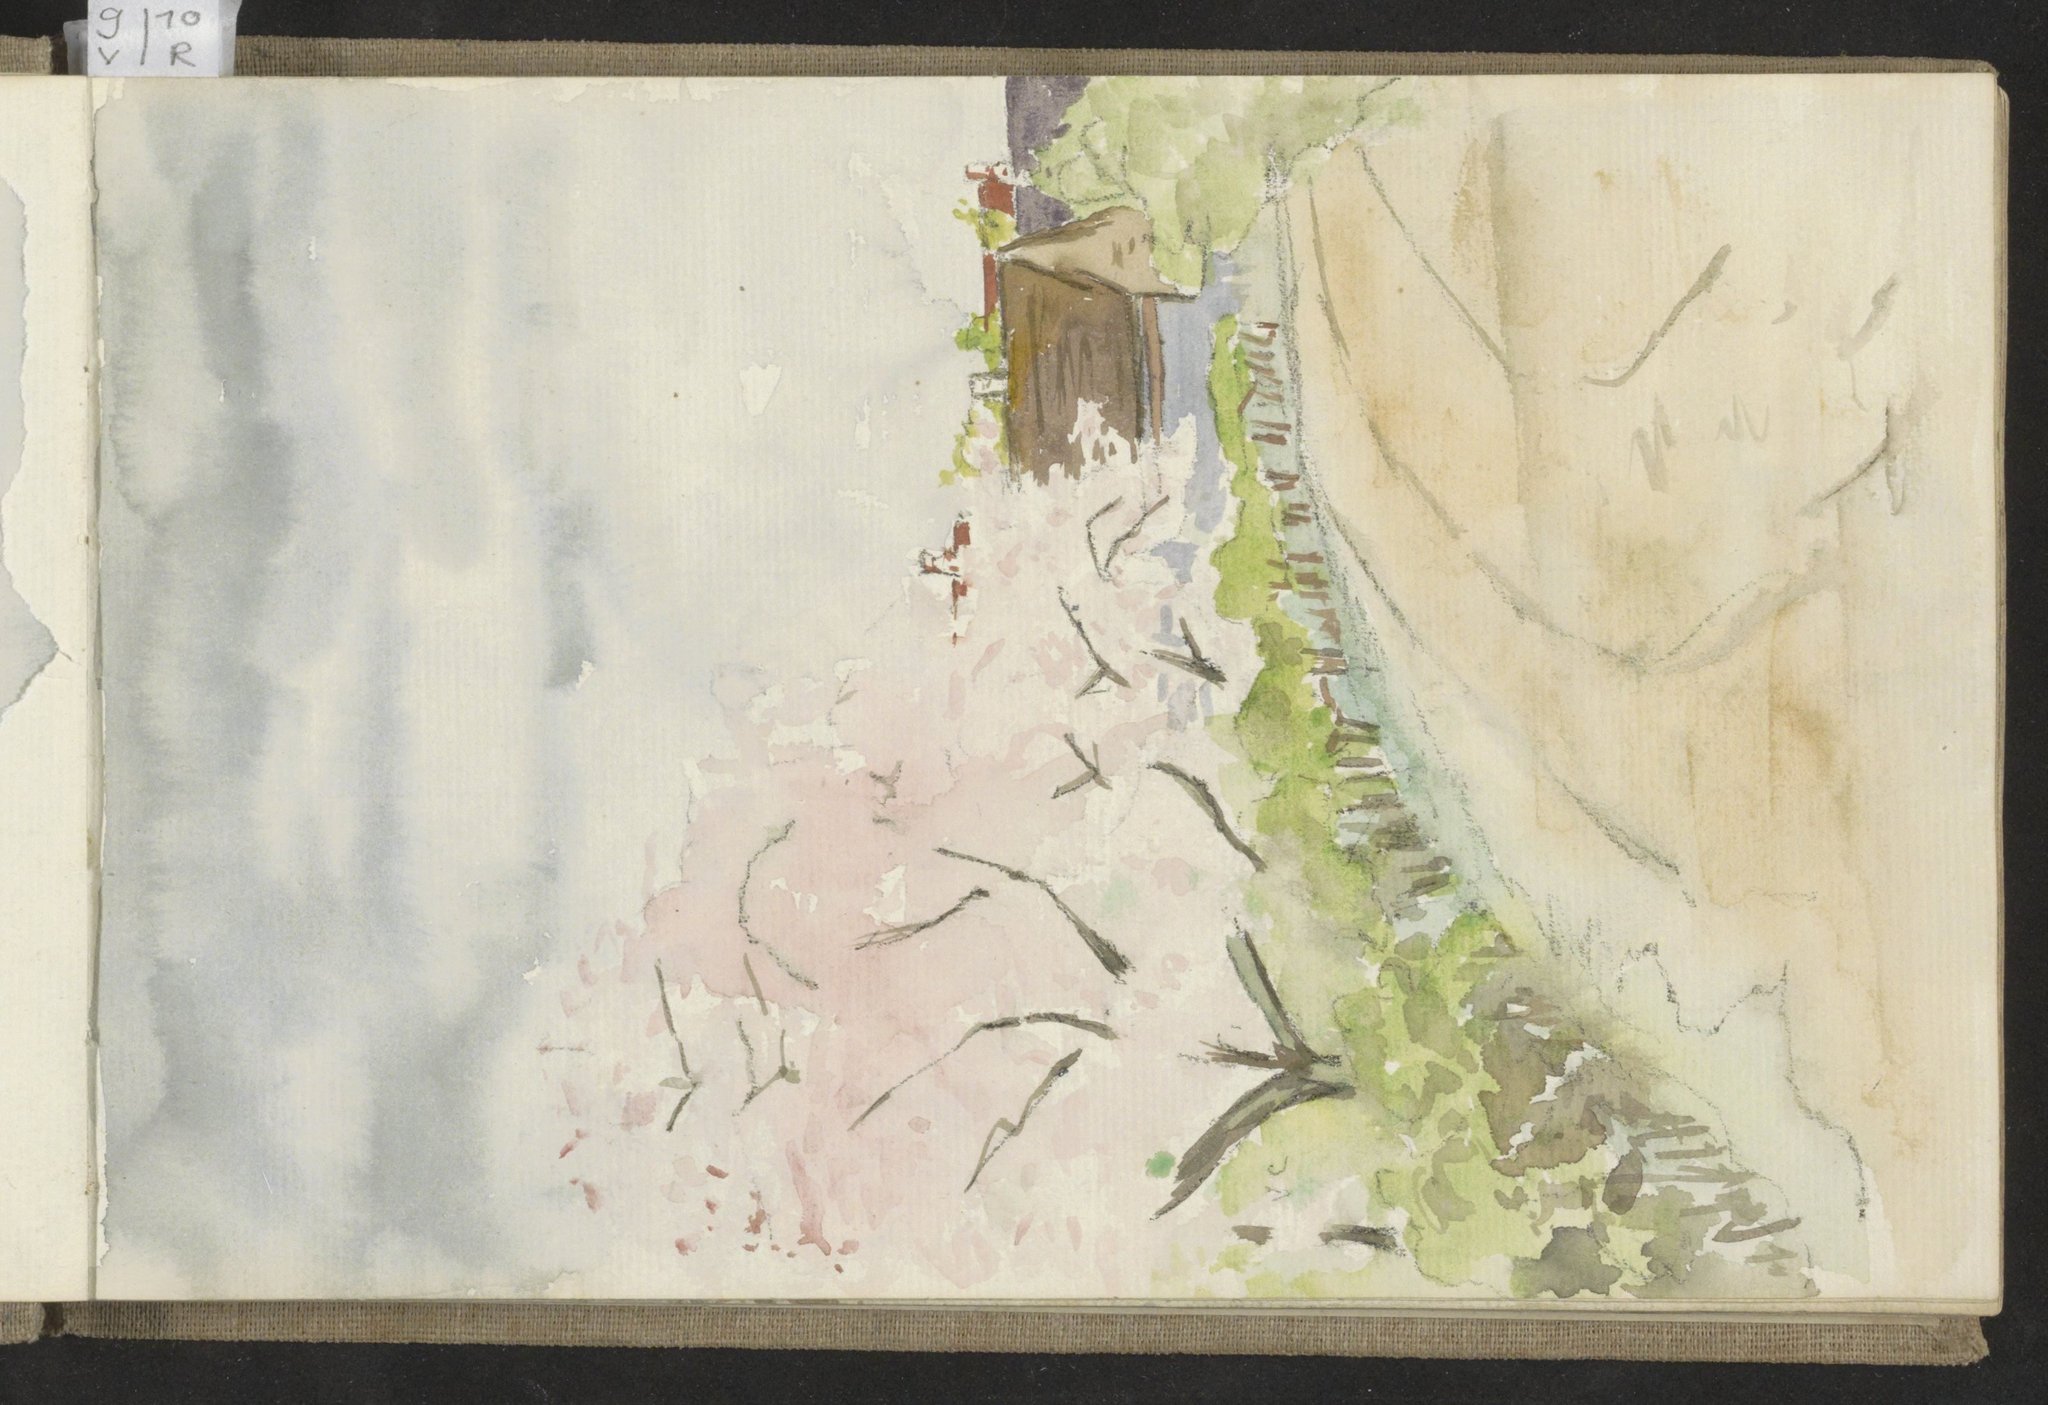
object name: sketchbook leaf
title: Bomen en huizen langs een landweg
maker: jonkheer johannes ludovicus paulus bosch van drakestein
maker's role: draughtsman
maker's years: 1865-1929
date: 1896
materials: paper, pencil, watercolor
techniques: brush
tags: road, path, the usual house or row of houses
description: Blad 8 recto uit een schetsboek met 58 bladen.